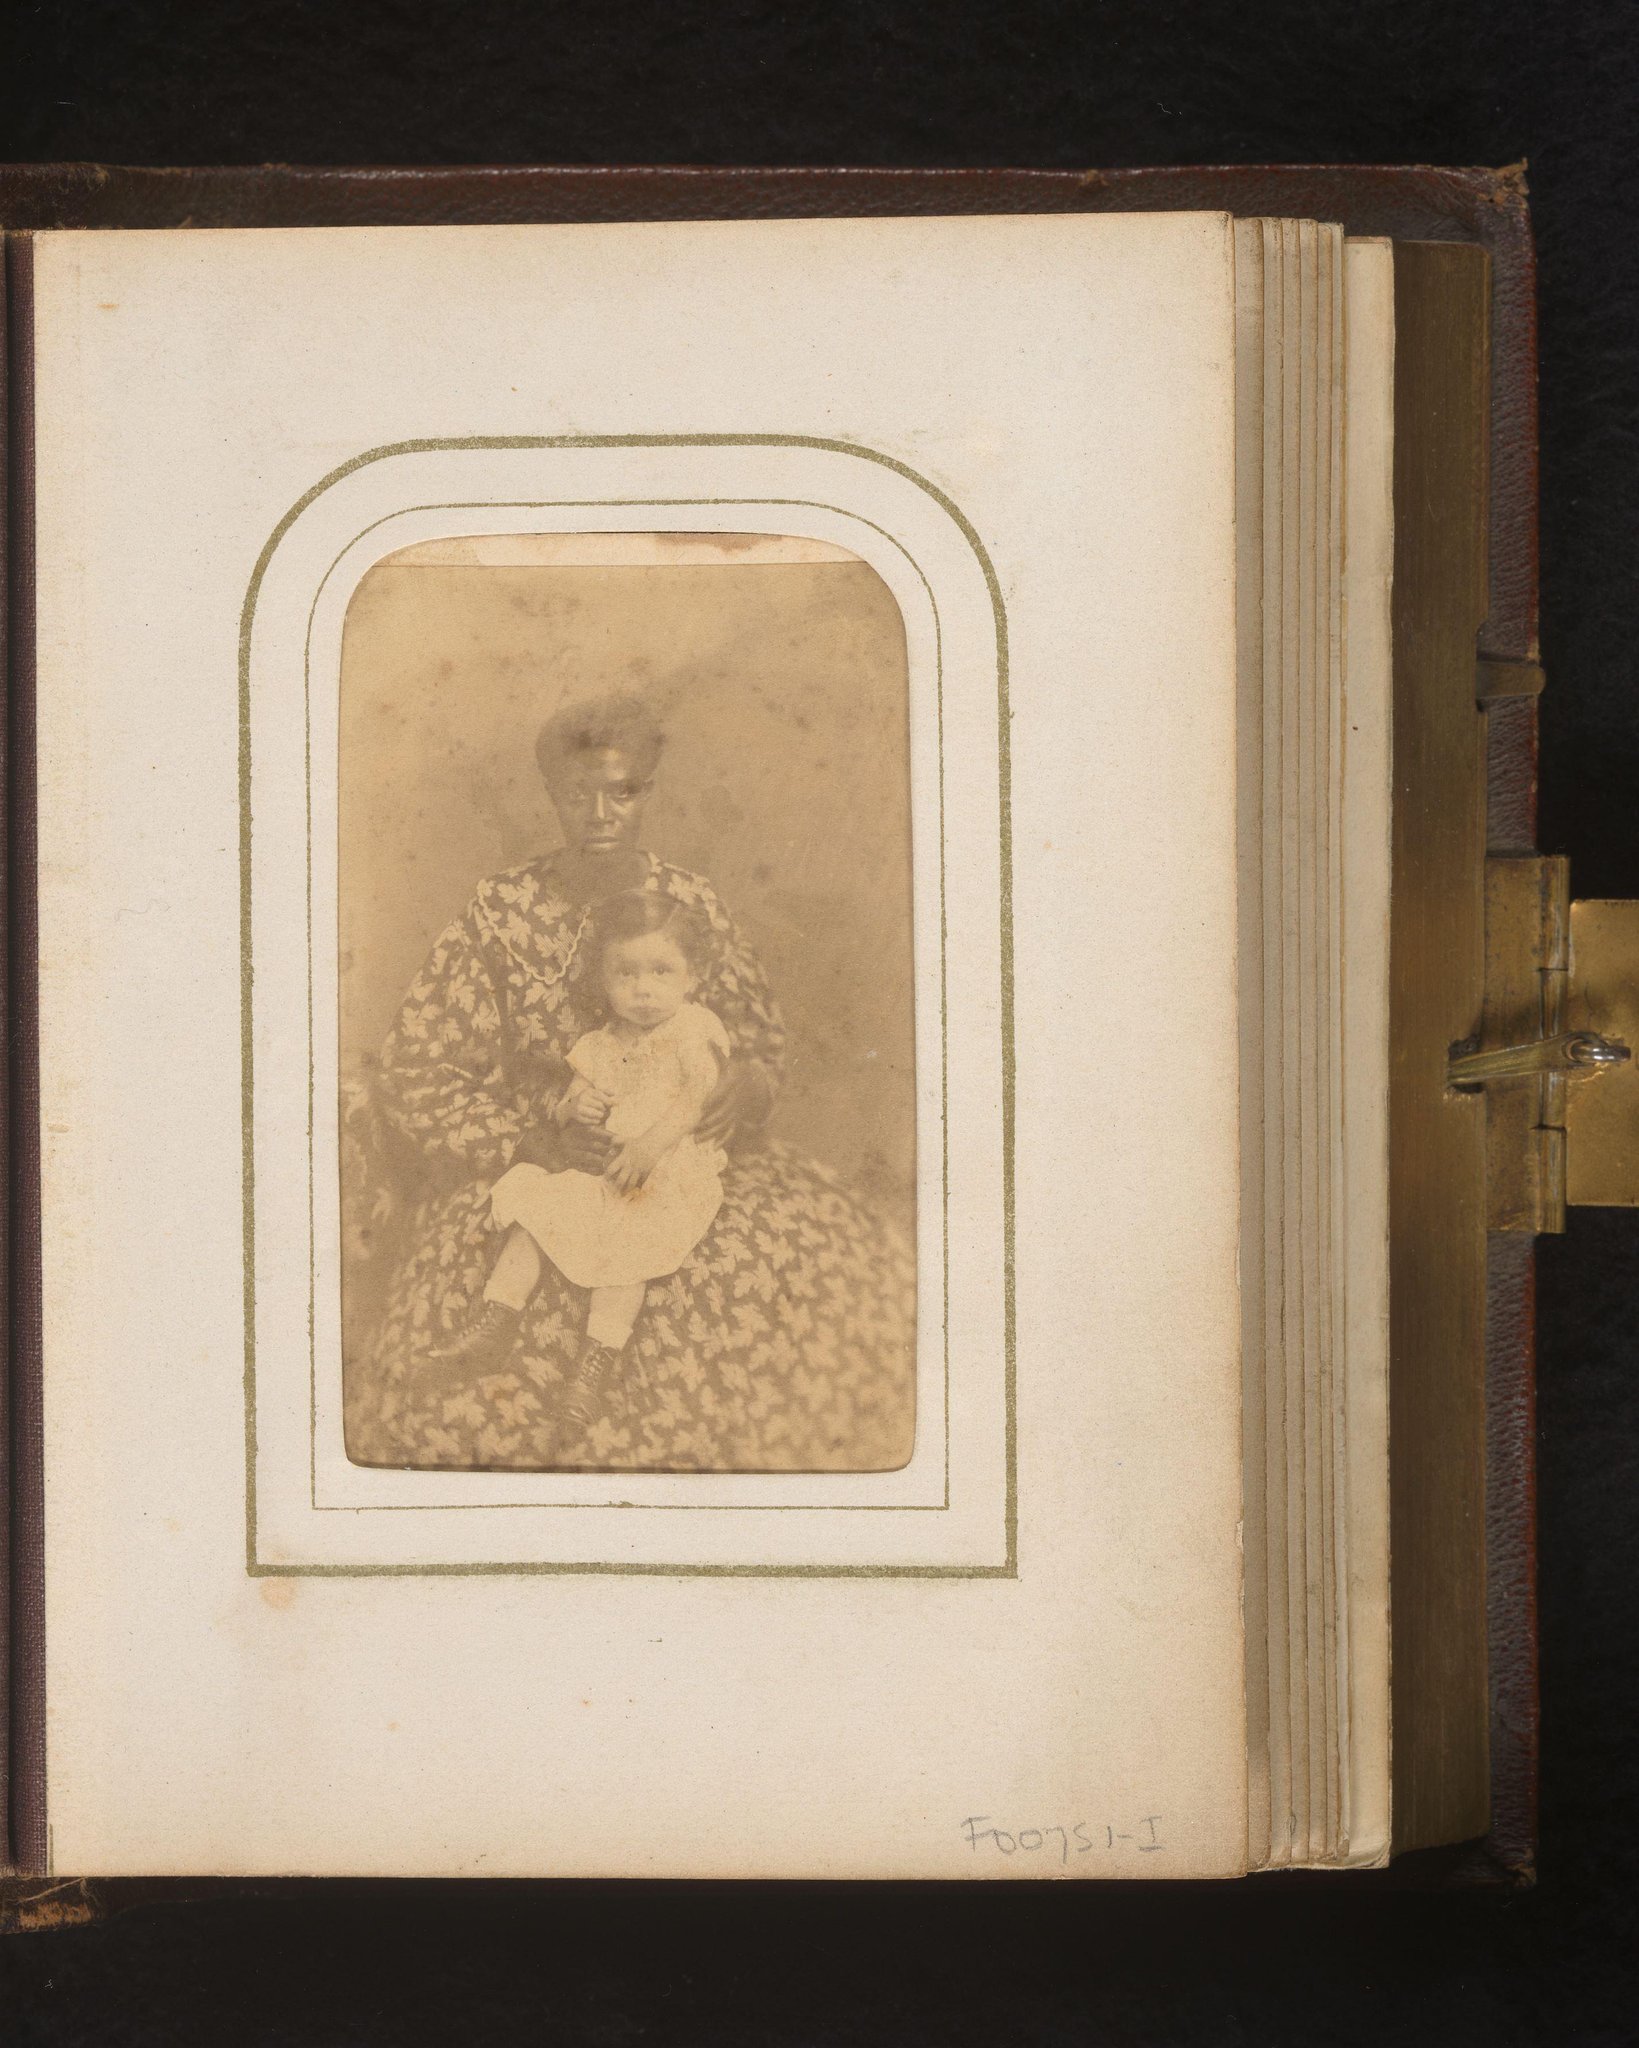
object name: carte de visite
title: Portret van een vrouw met een meisje op schoot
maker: Anonymous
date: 1860-1900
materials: cardboard, photographic support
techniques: albumen print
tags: adult woman, historical persons, girl (child between toddler and youth)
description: Portret van een zwarte vrouw met een wit meisje op schoot. Deze foto maakt deel uit van een album.